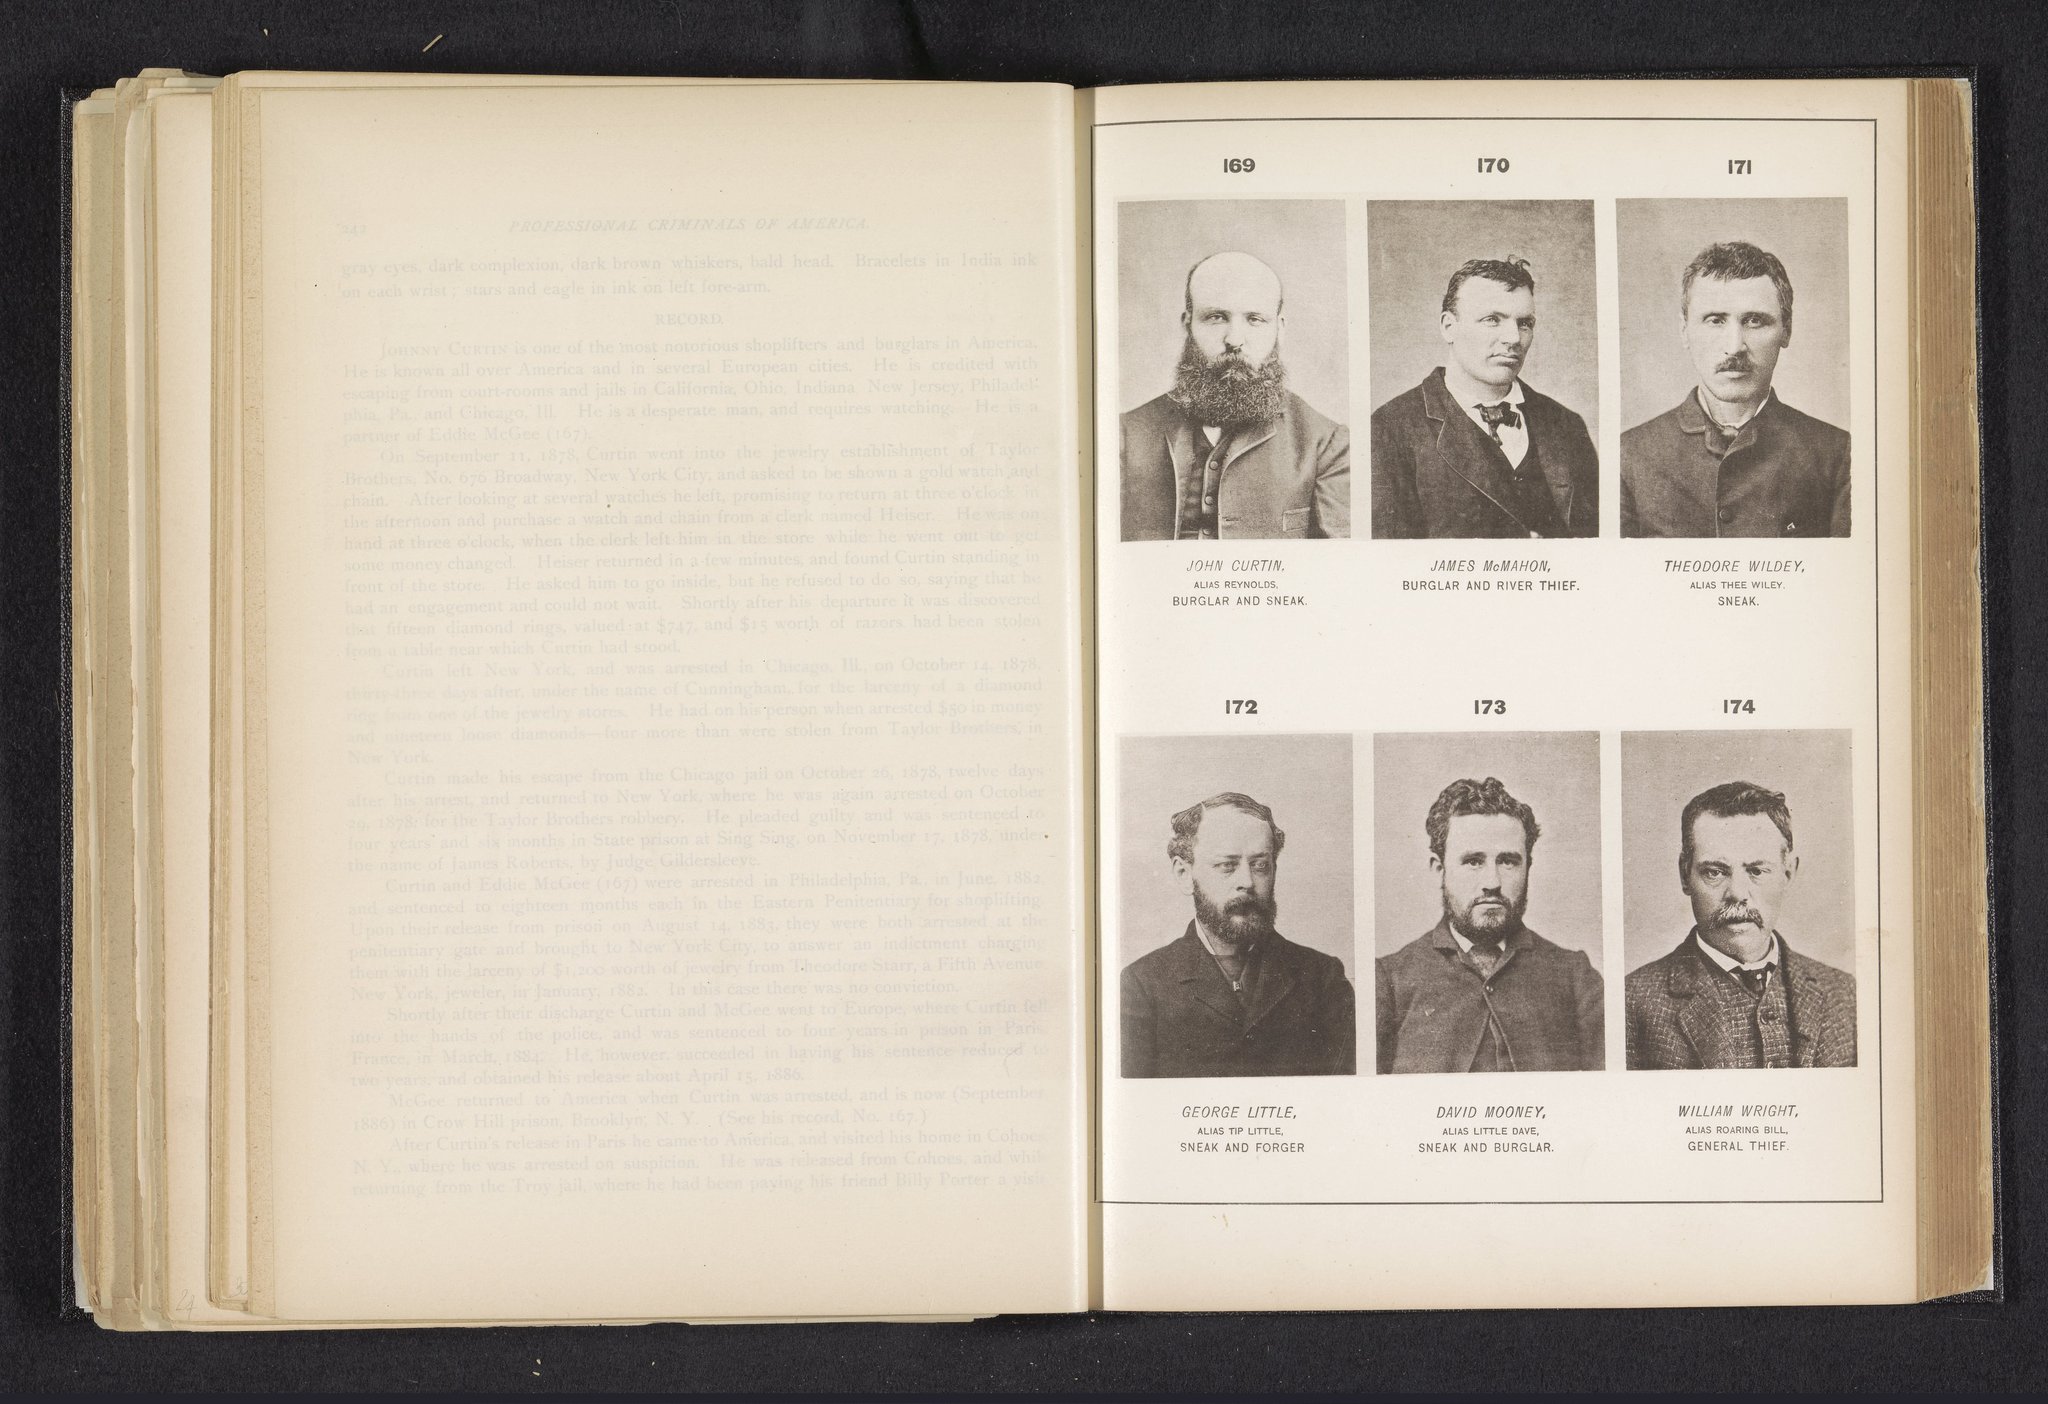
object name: page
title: Zes portretten van inbrekers en oplichters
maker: Anonymous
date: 1881-1886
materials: paper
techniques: photograph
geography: boston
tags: historical persons not known by name (+ (full) bust portrait), burglar, housebreaker, counterfeiter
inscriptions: inscription: ‘John Curtin (...) general thief.’, number: ‘169 (...) 174’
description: Linksboven John Curtin, midden boven James McMahon, rechtsboven Theodore Wildey, linksonder George Little, midden onder David Mooney, rechtsonder William Wright.